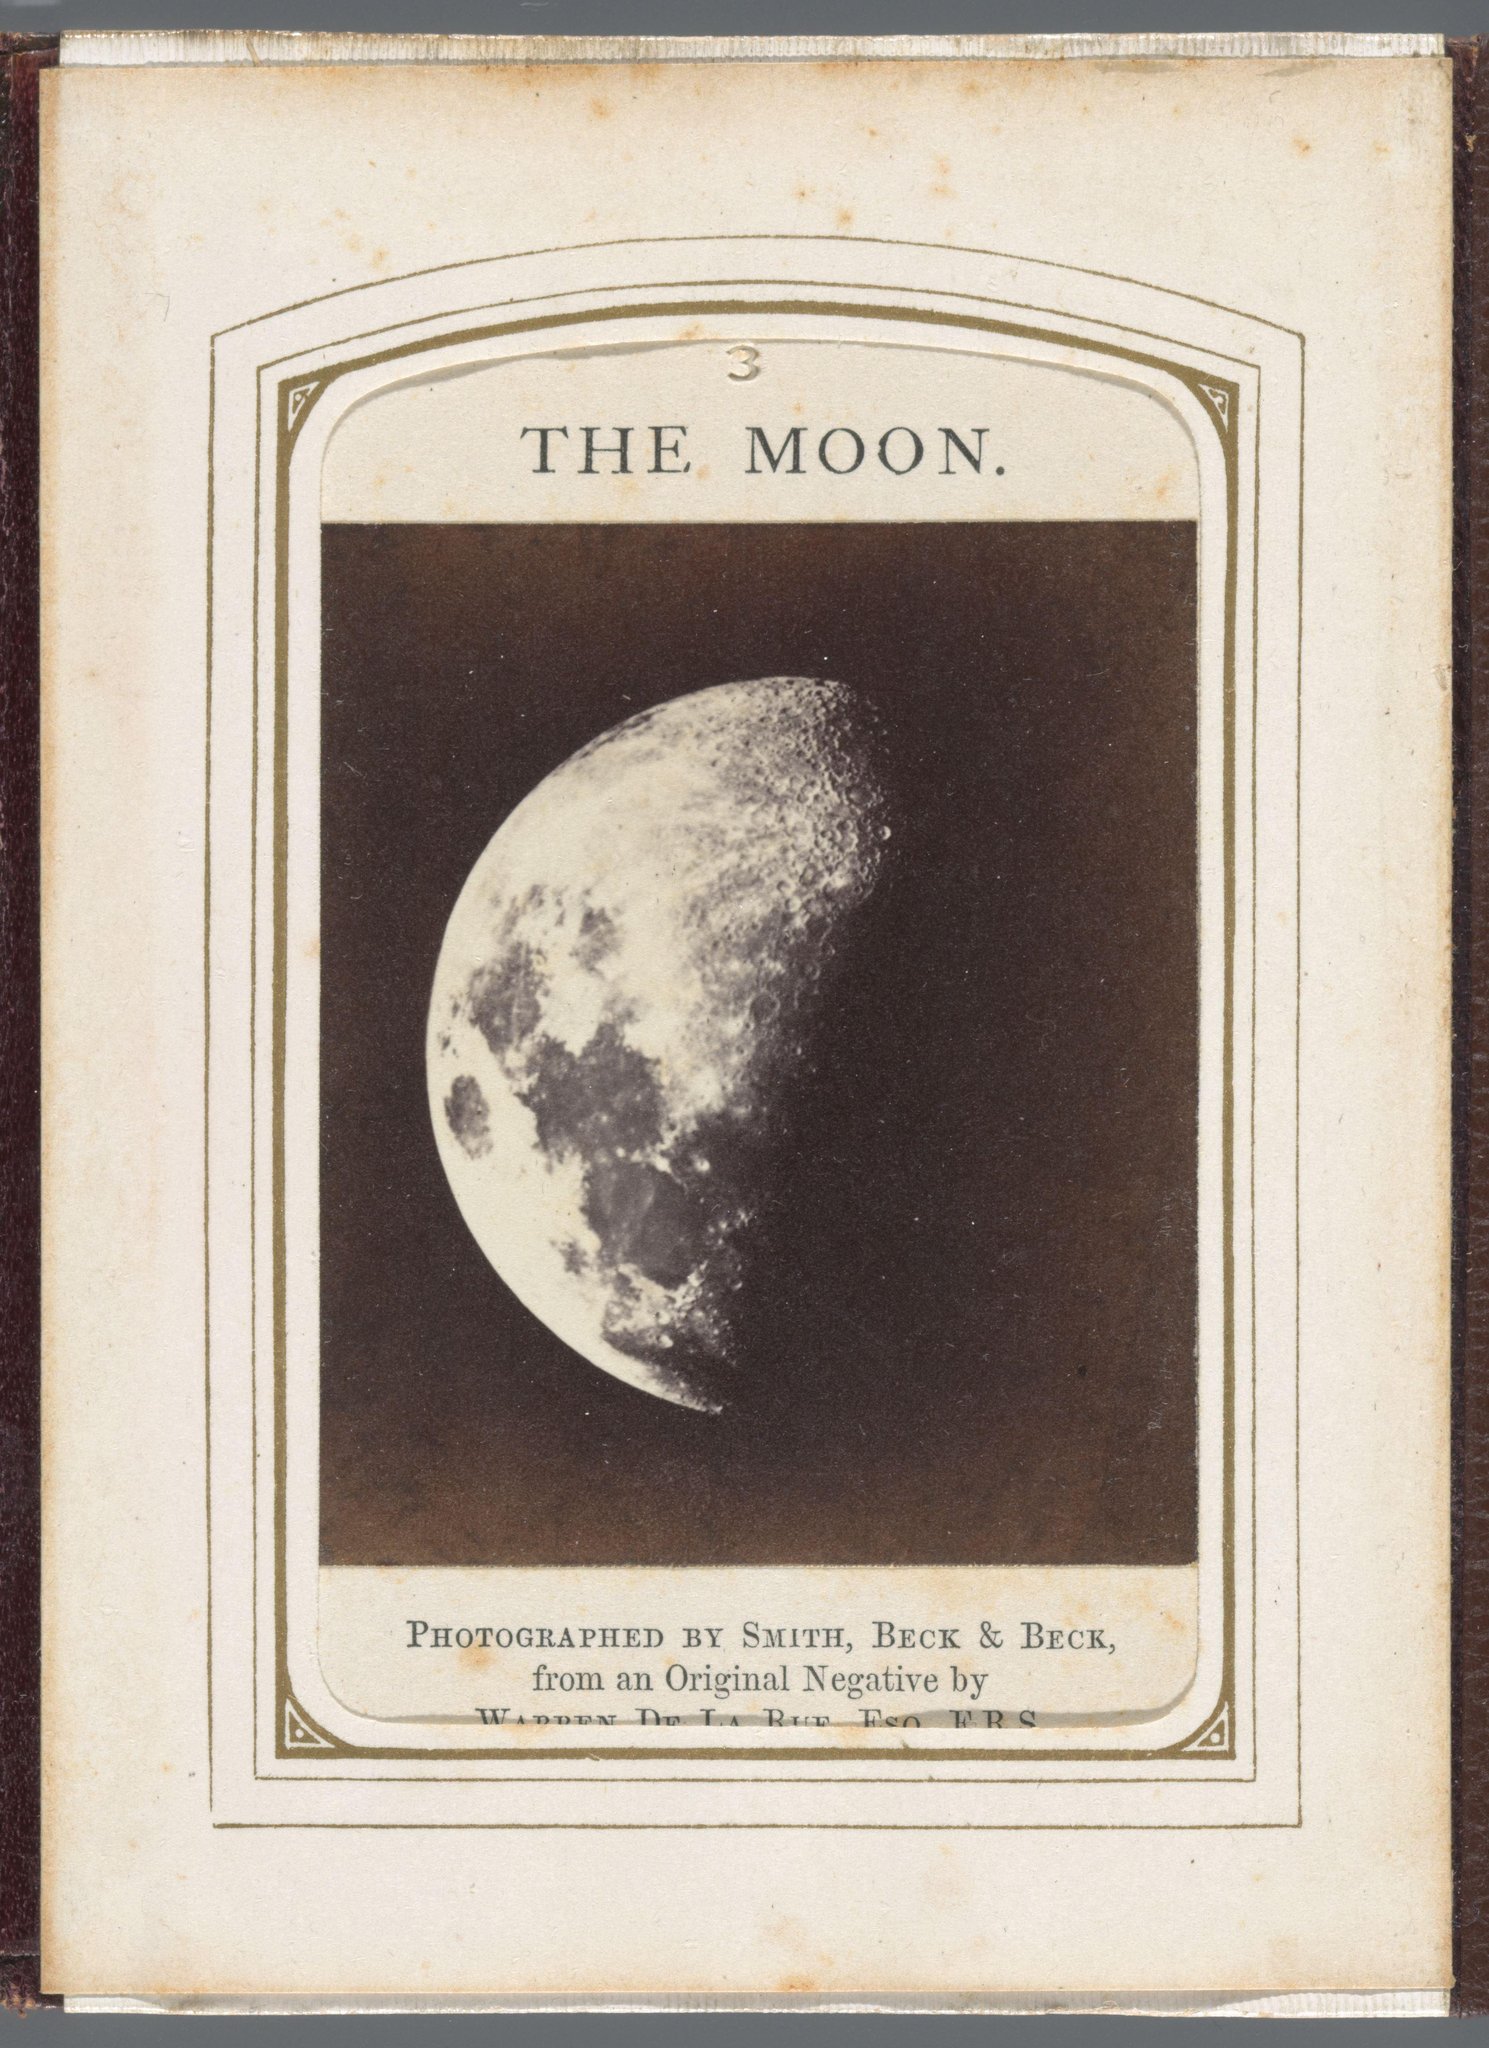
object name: album leaf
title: Wassende maan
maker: warren de la rue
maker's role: astronoom, fotograaf, scheikundige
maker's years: 1815-1889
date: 1866-1880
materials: cardboard, paper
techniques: albumen print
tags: waning moon, i.e. facing this way (, moon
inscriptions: inscription: ‘PHOTOGRAPHED BY SMITH, BECK & BECK,/ from an Original Negative by/WARREN DE LA RUE, ESQ, F.R.S.’